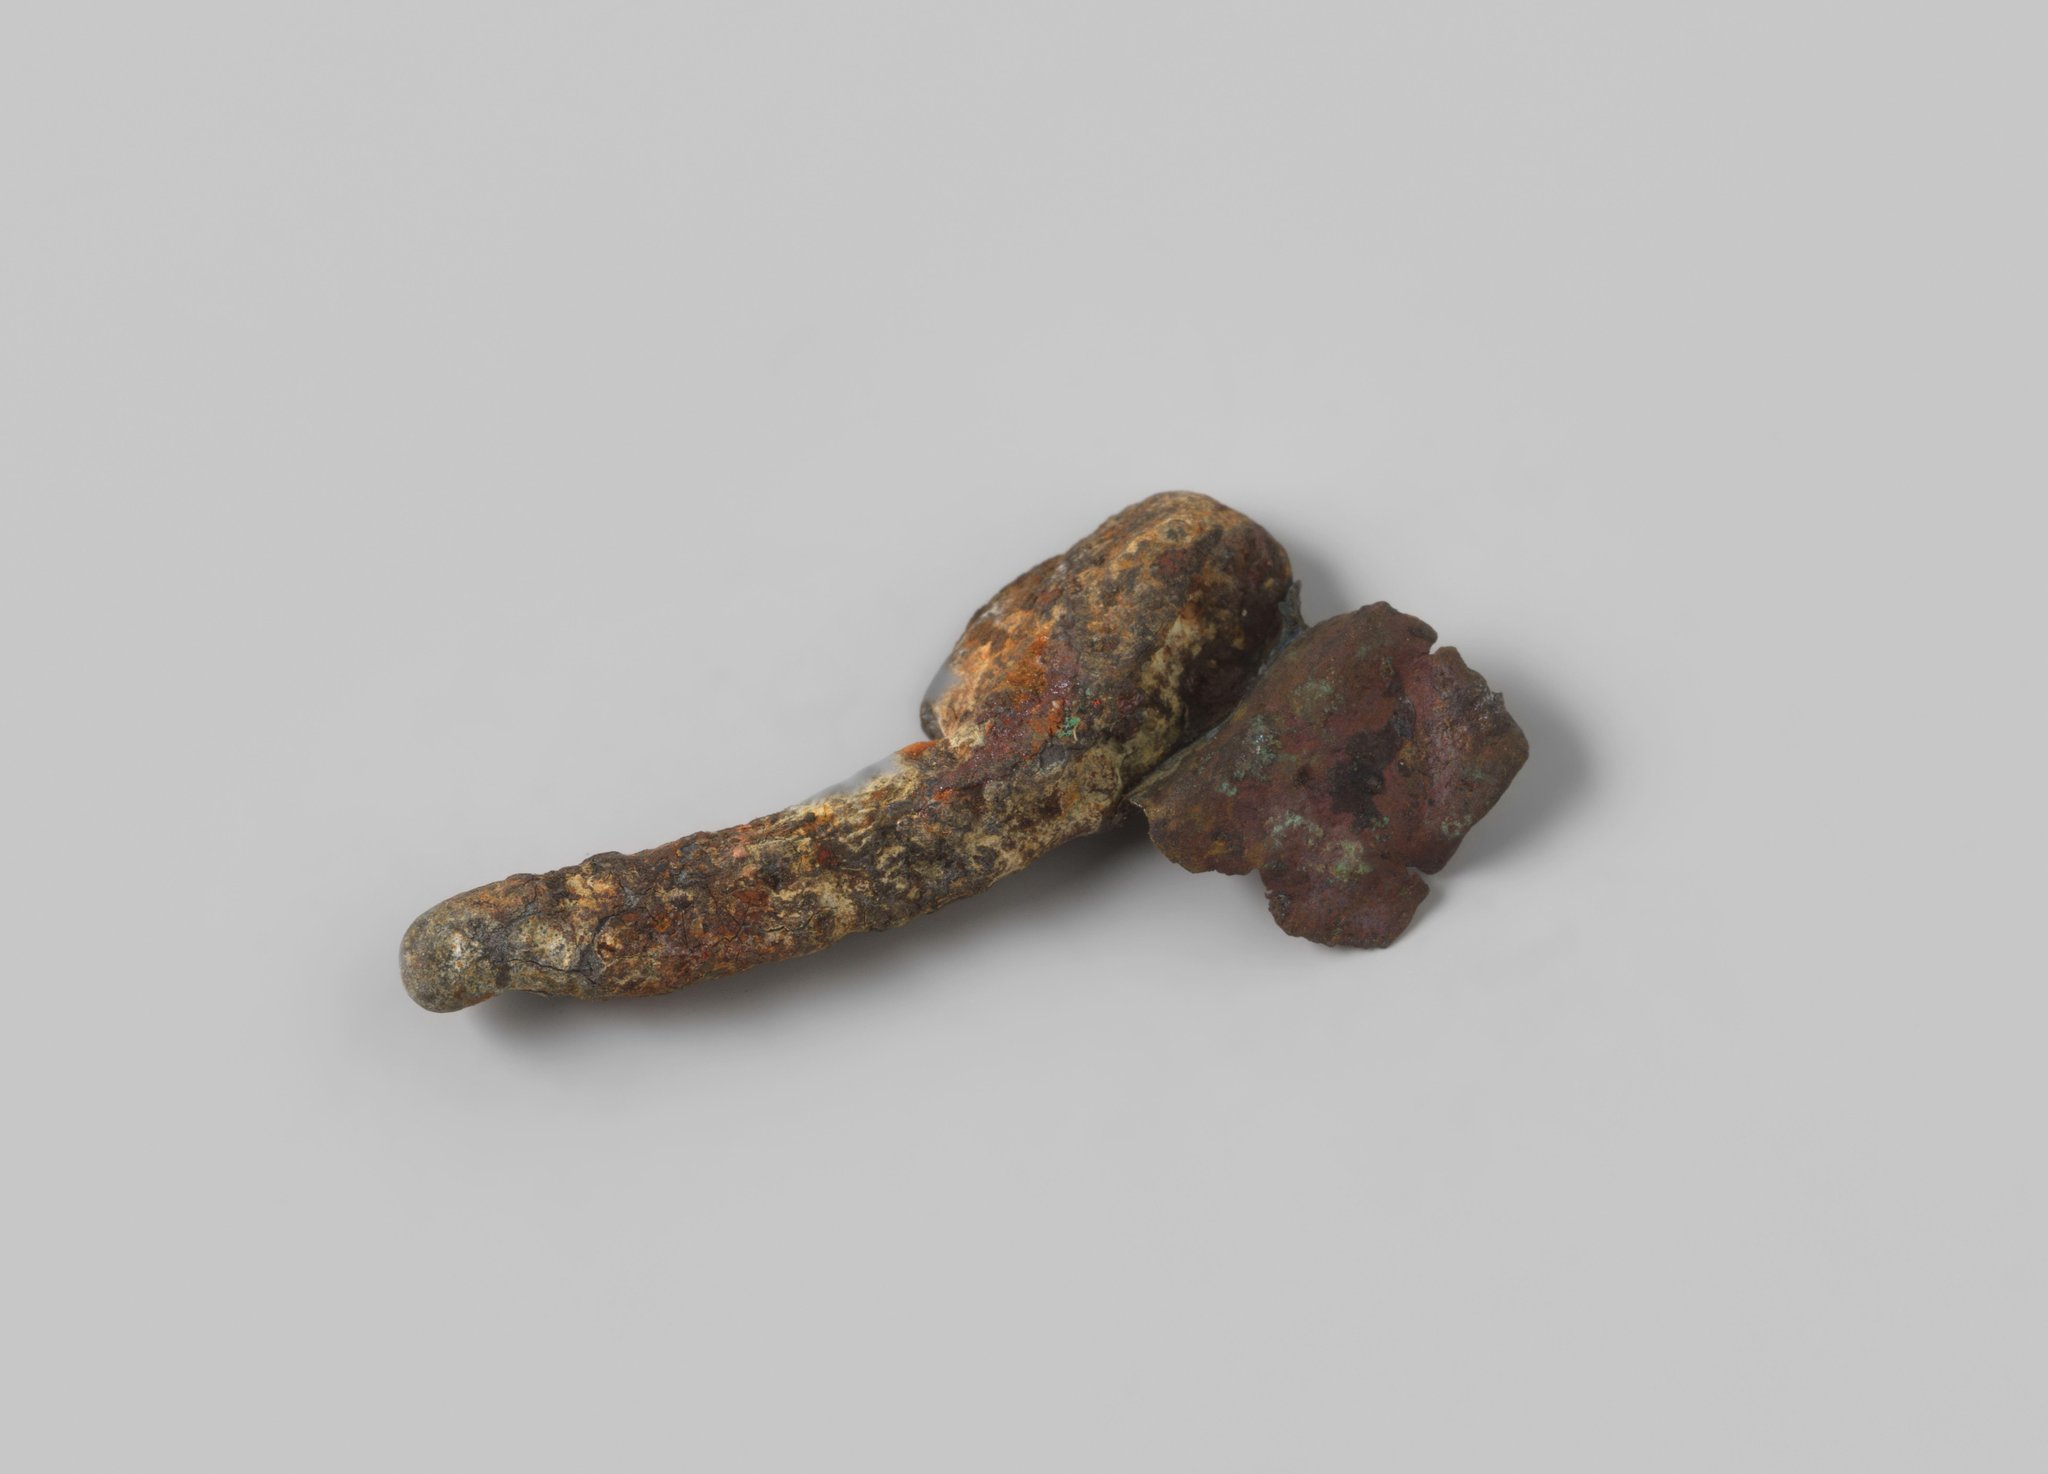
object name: cartridge shell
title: Fragment patroonhuls met beslag uit het wrak van de Oost-Indiëvaarder Hollandia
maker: Anonymous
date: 1700-1743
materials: copper, lead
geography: netherlands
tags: verenigde oostindische compagnie, hollandia (schip), annet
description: Cartridge case, tube solder; id. NG 1979-205H549 with copper tube fragm.